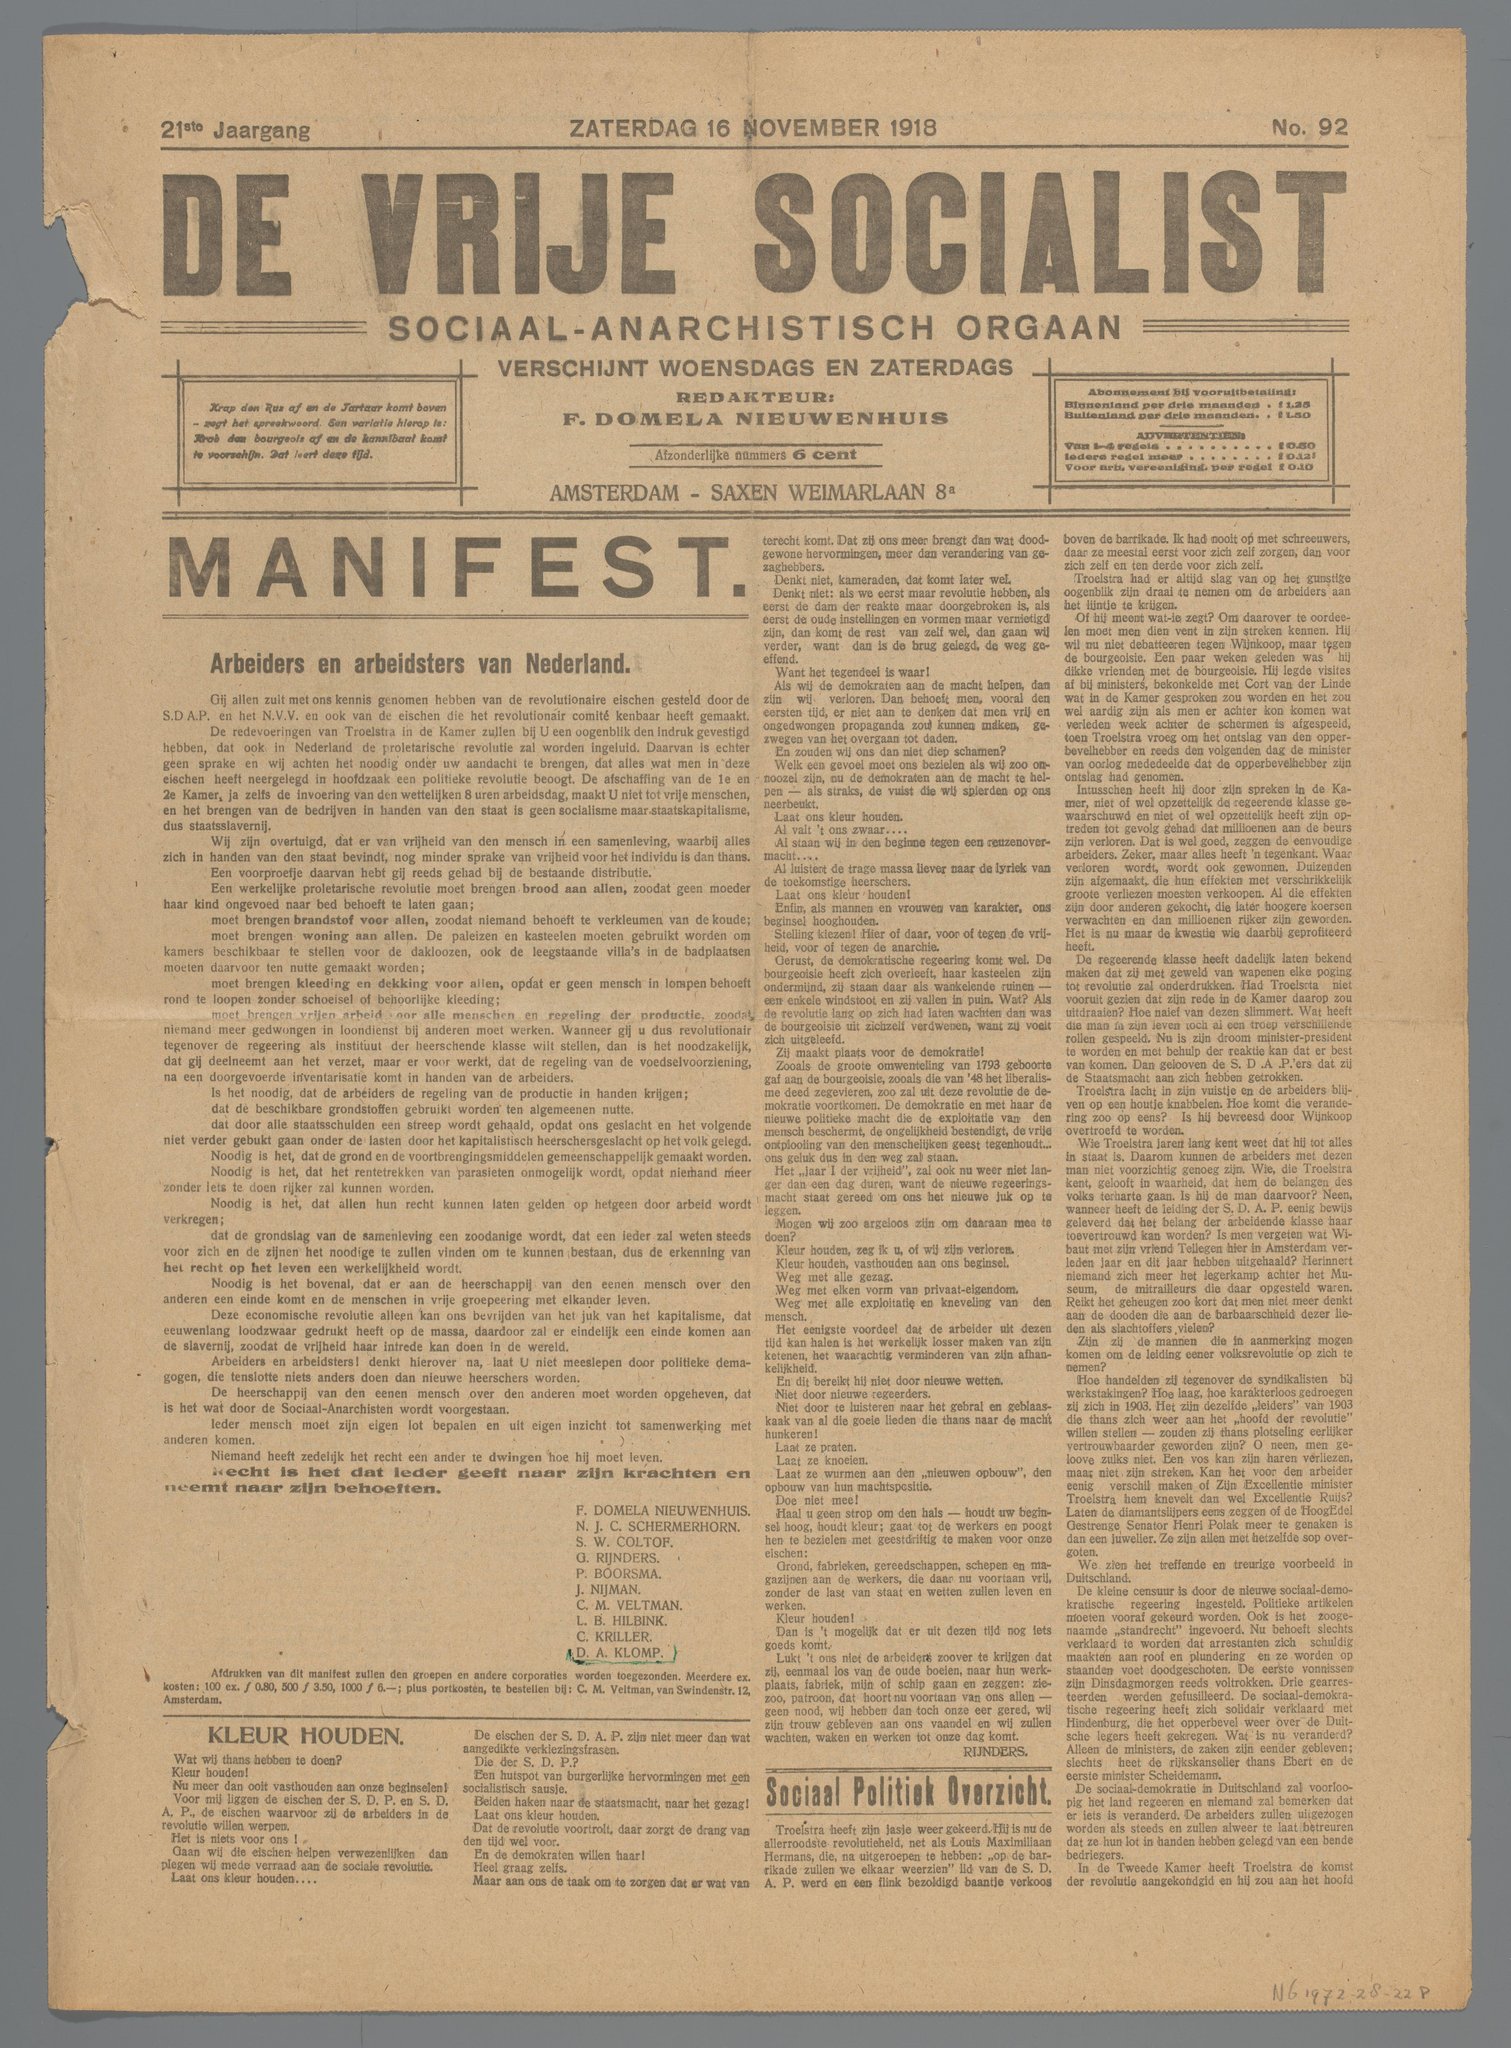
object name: newspaper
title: De Vrije Socialist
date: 1918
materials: paper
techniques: printing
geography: amsterdam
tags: netherlands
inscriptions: date